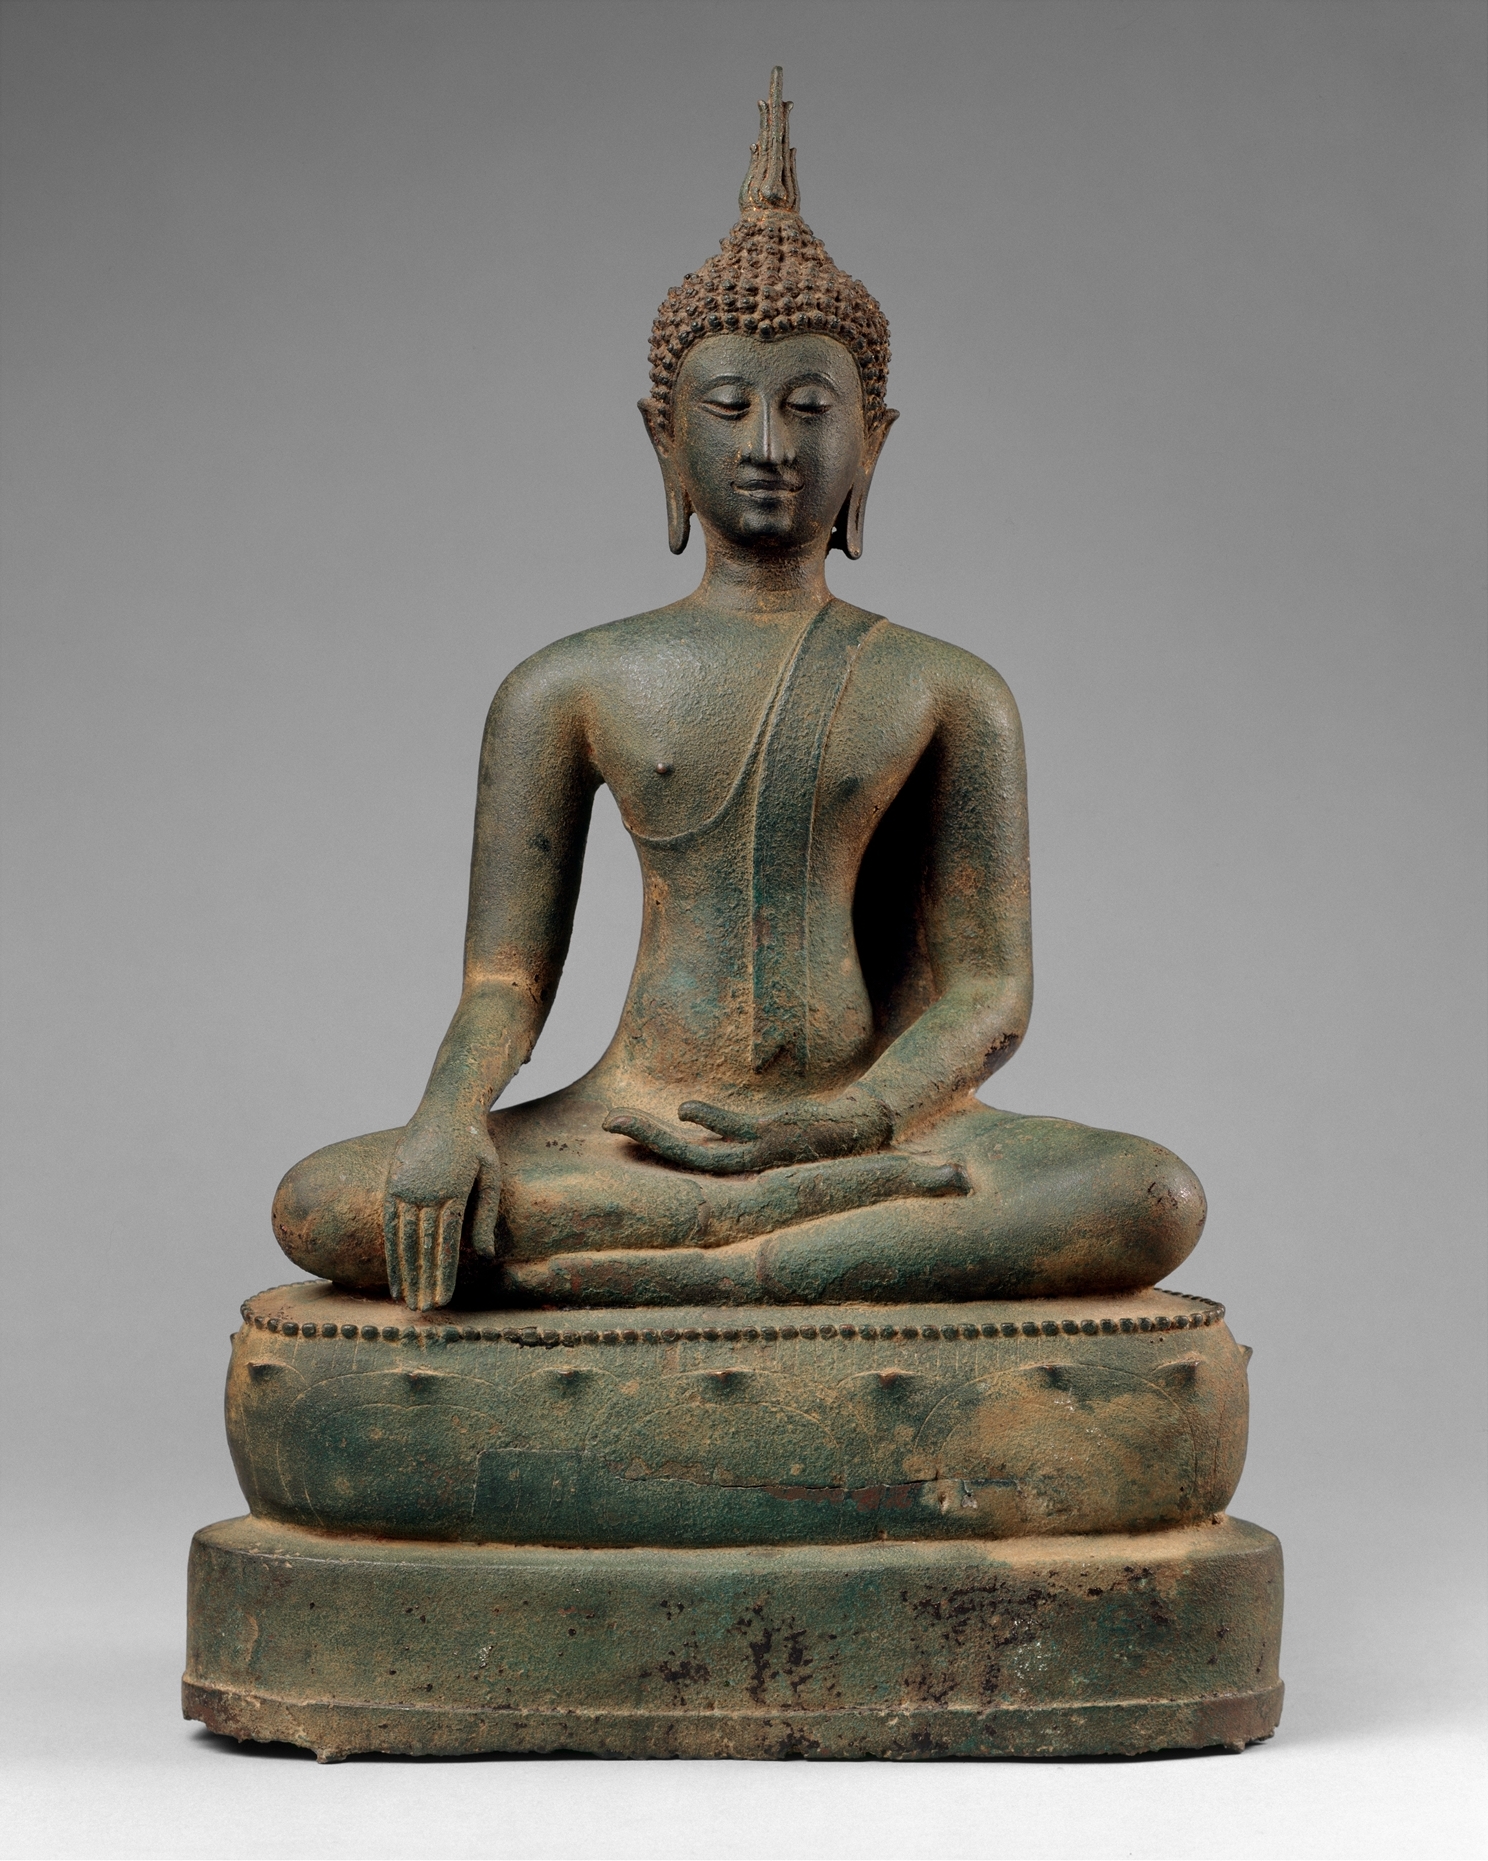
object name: figure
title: Seated Buddha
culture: thai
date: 1467-1600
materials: bronze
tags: buddhism,buddha